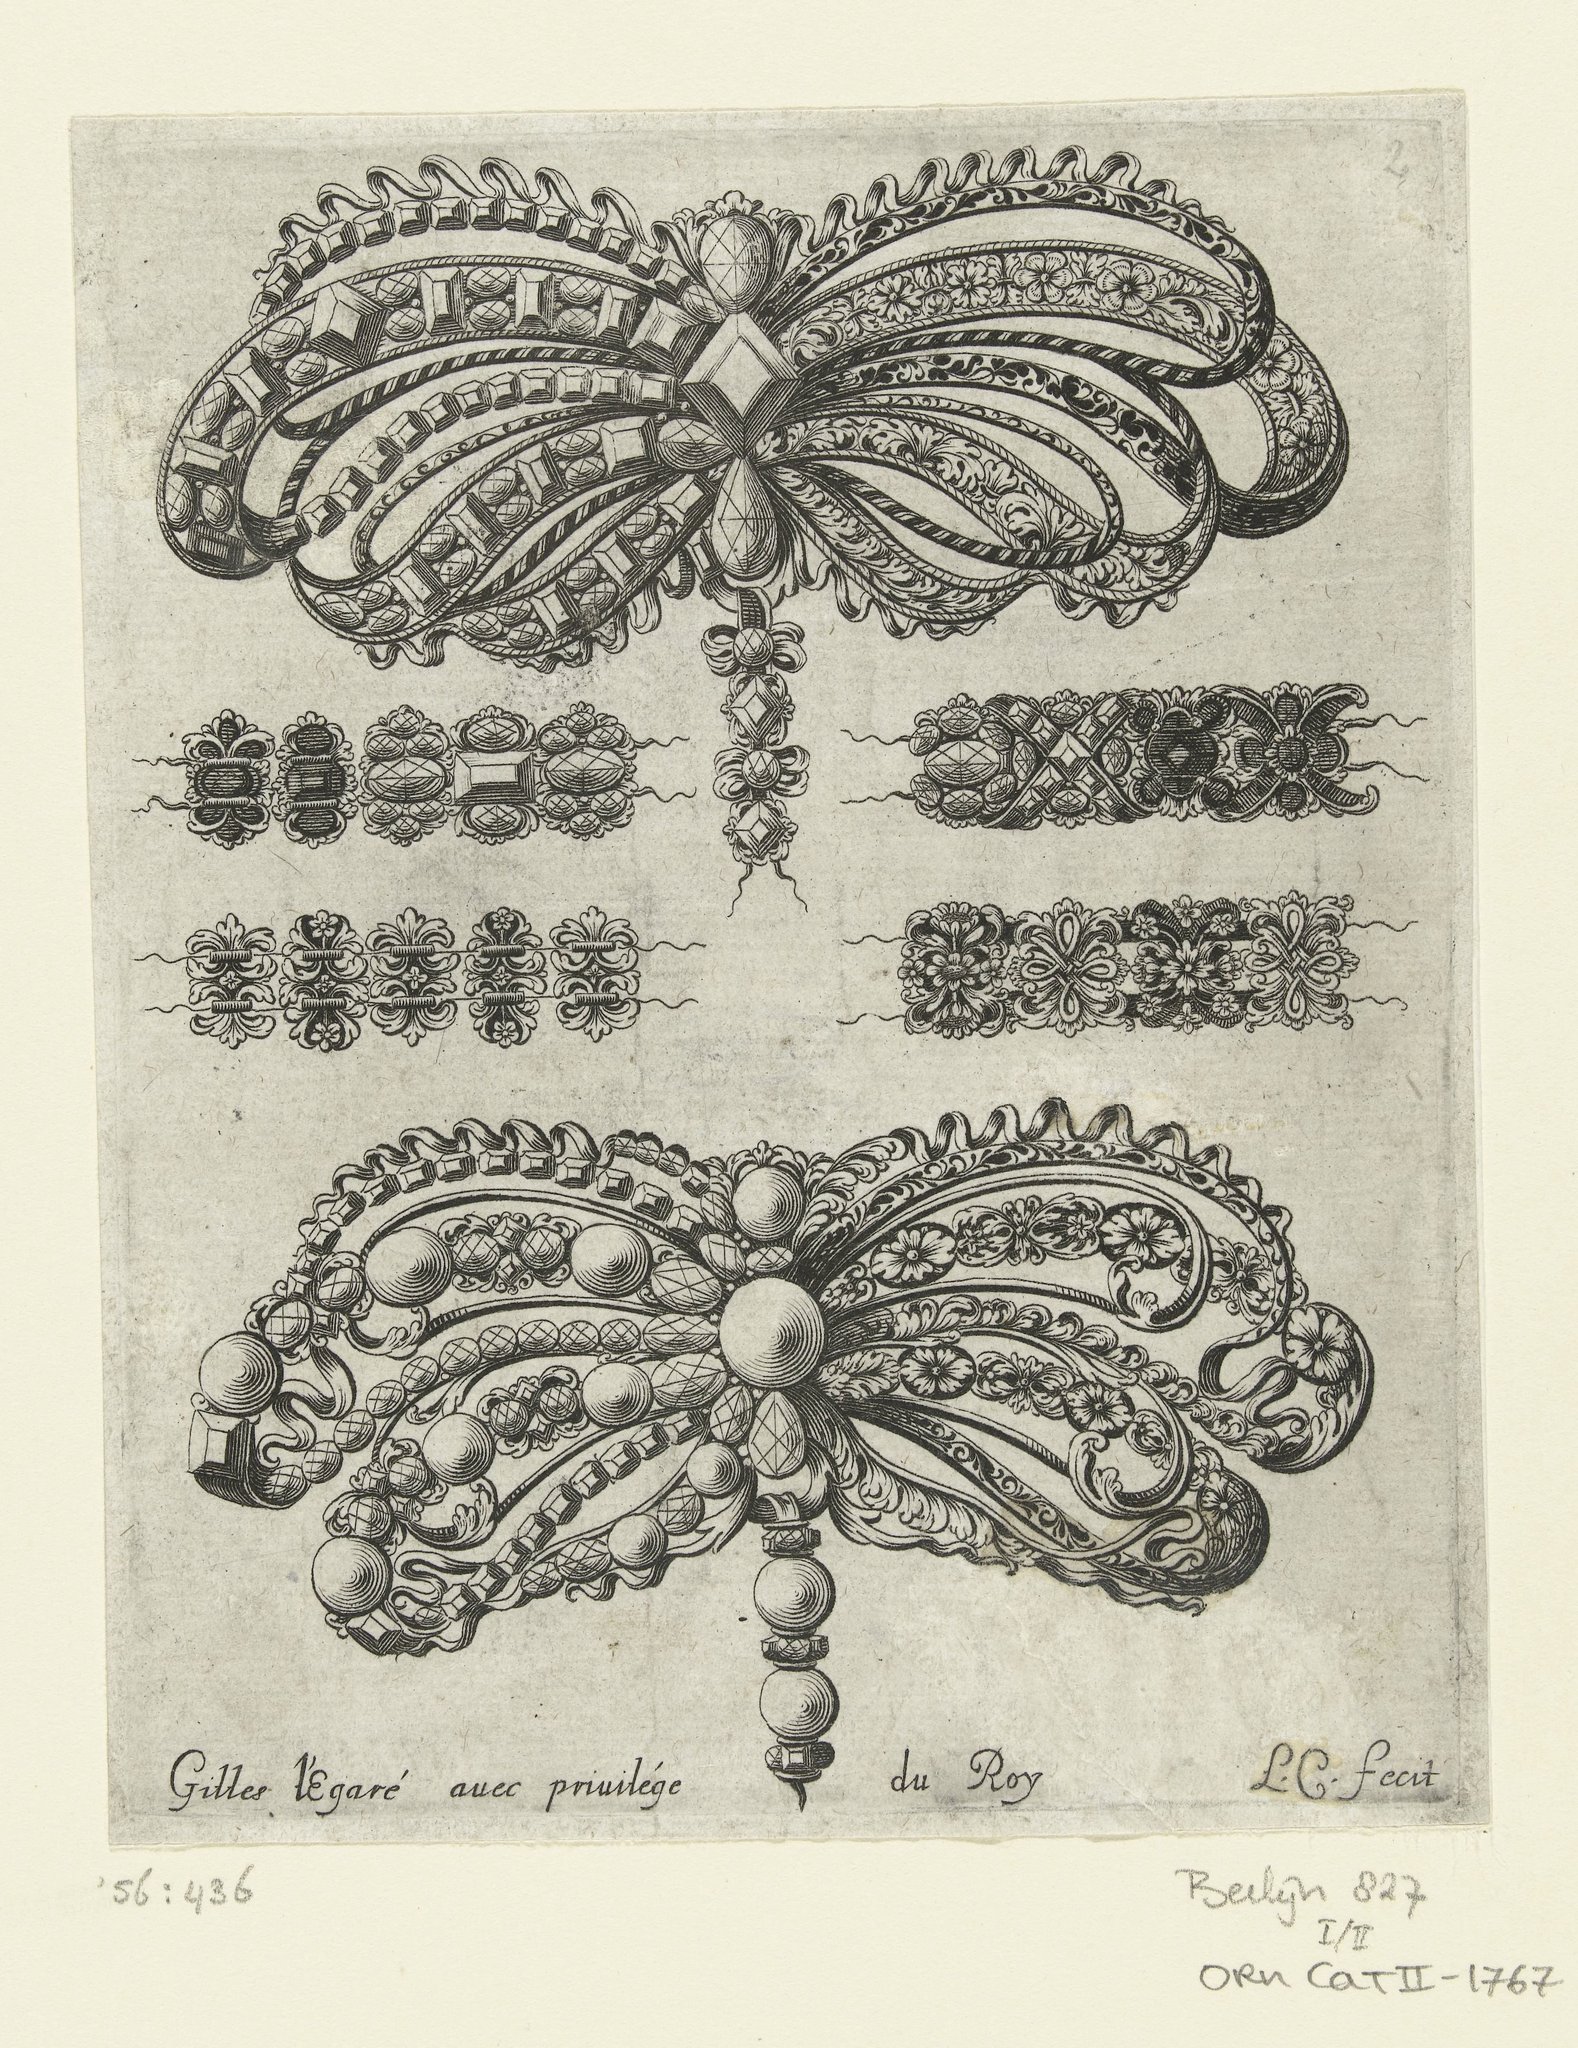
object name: ornament print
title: Livre des Ouvrages d'Orfevrerie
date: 1663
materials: paper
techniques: engraving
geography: paris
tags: brooch, agraffe, clasp, necklace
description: Boven- en onderaan is een broche in de vorm van een strik afgebeeld, ertussen vier ontwerpen voor kettingschakels met varianten, gedeeltelijk van de achterkant gezien. Blad 2 uit serie van 8 bladen met ontwerpen voor juwelen.